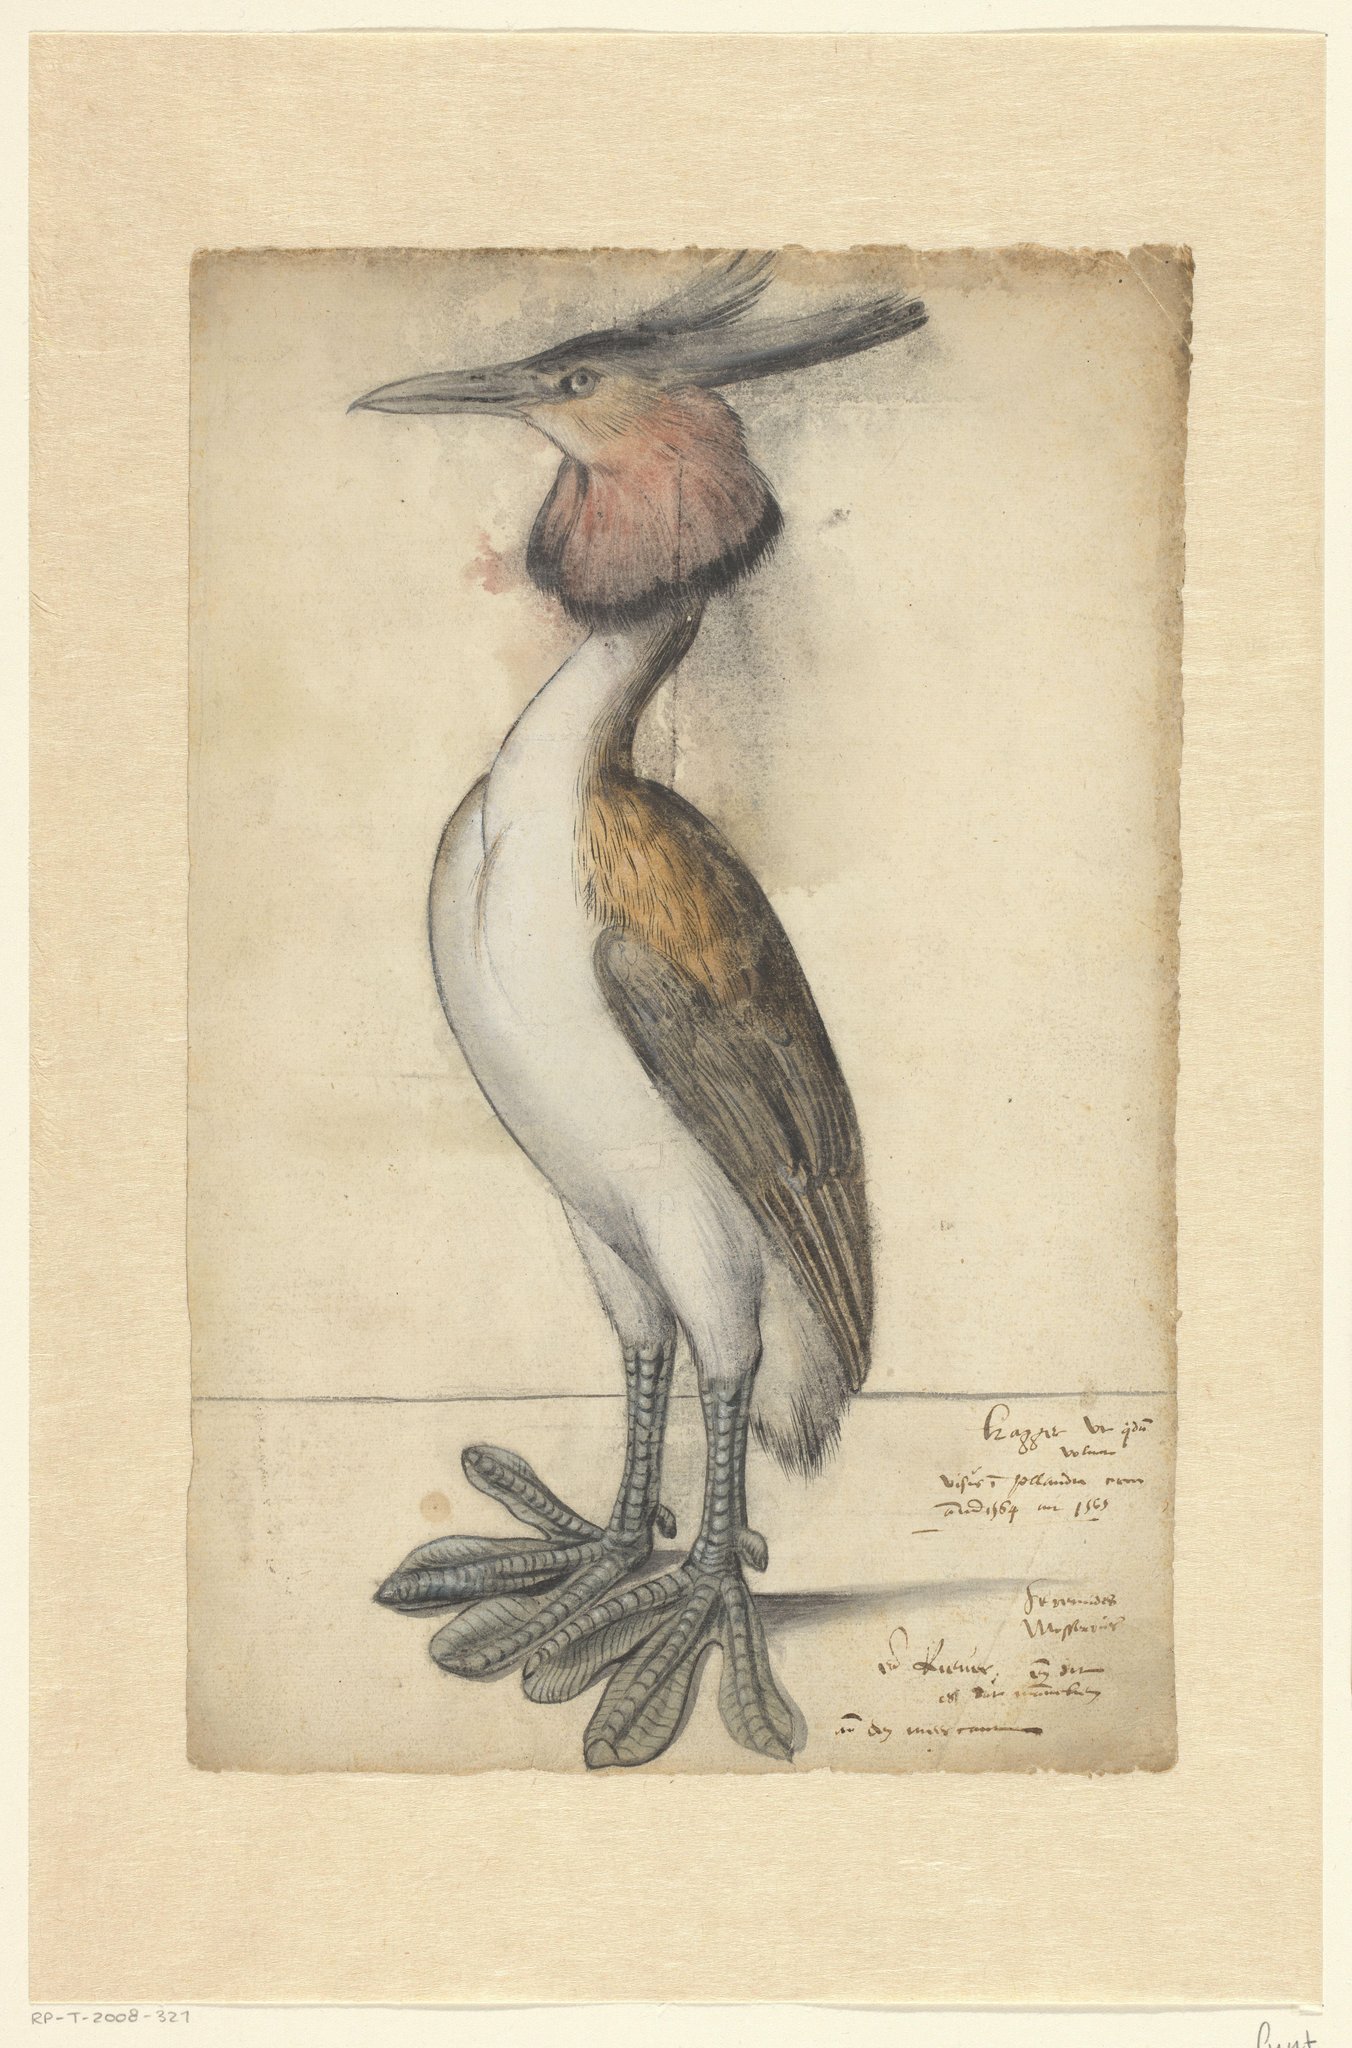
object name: drawing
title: Great Crested Grebe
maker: Anonymous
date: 1564-1565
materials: paint, graphite, ink, paper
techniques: brush, pen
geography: netherlands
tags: birds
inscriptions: watermark, inscription: ‘Hagger ut qdū (quidam)/ volunt/ visus ī (in) Hollandia circum/ annum 1564 aut 1565/ Heremides/ Mosserus (or Mosservies?)/ vide (?) Riever (Kiever,?); ende dit/ es dat manneken/ van den Meercaut’